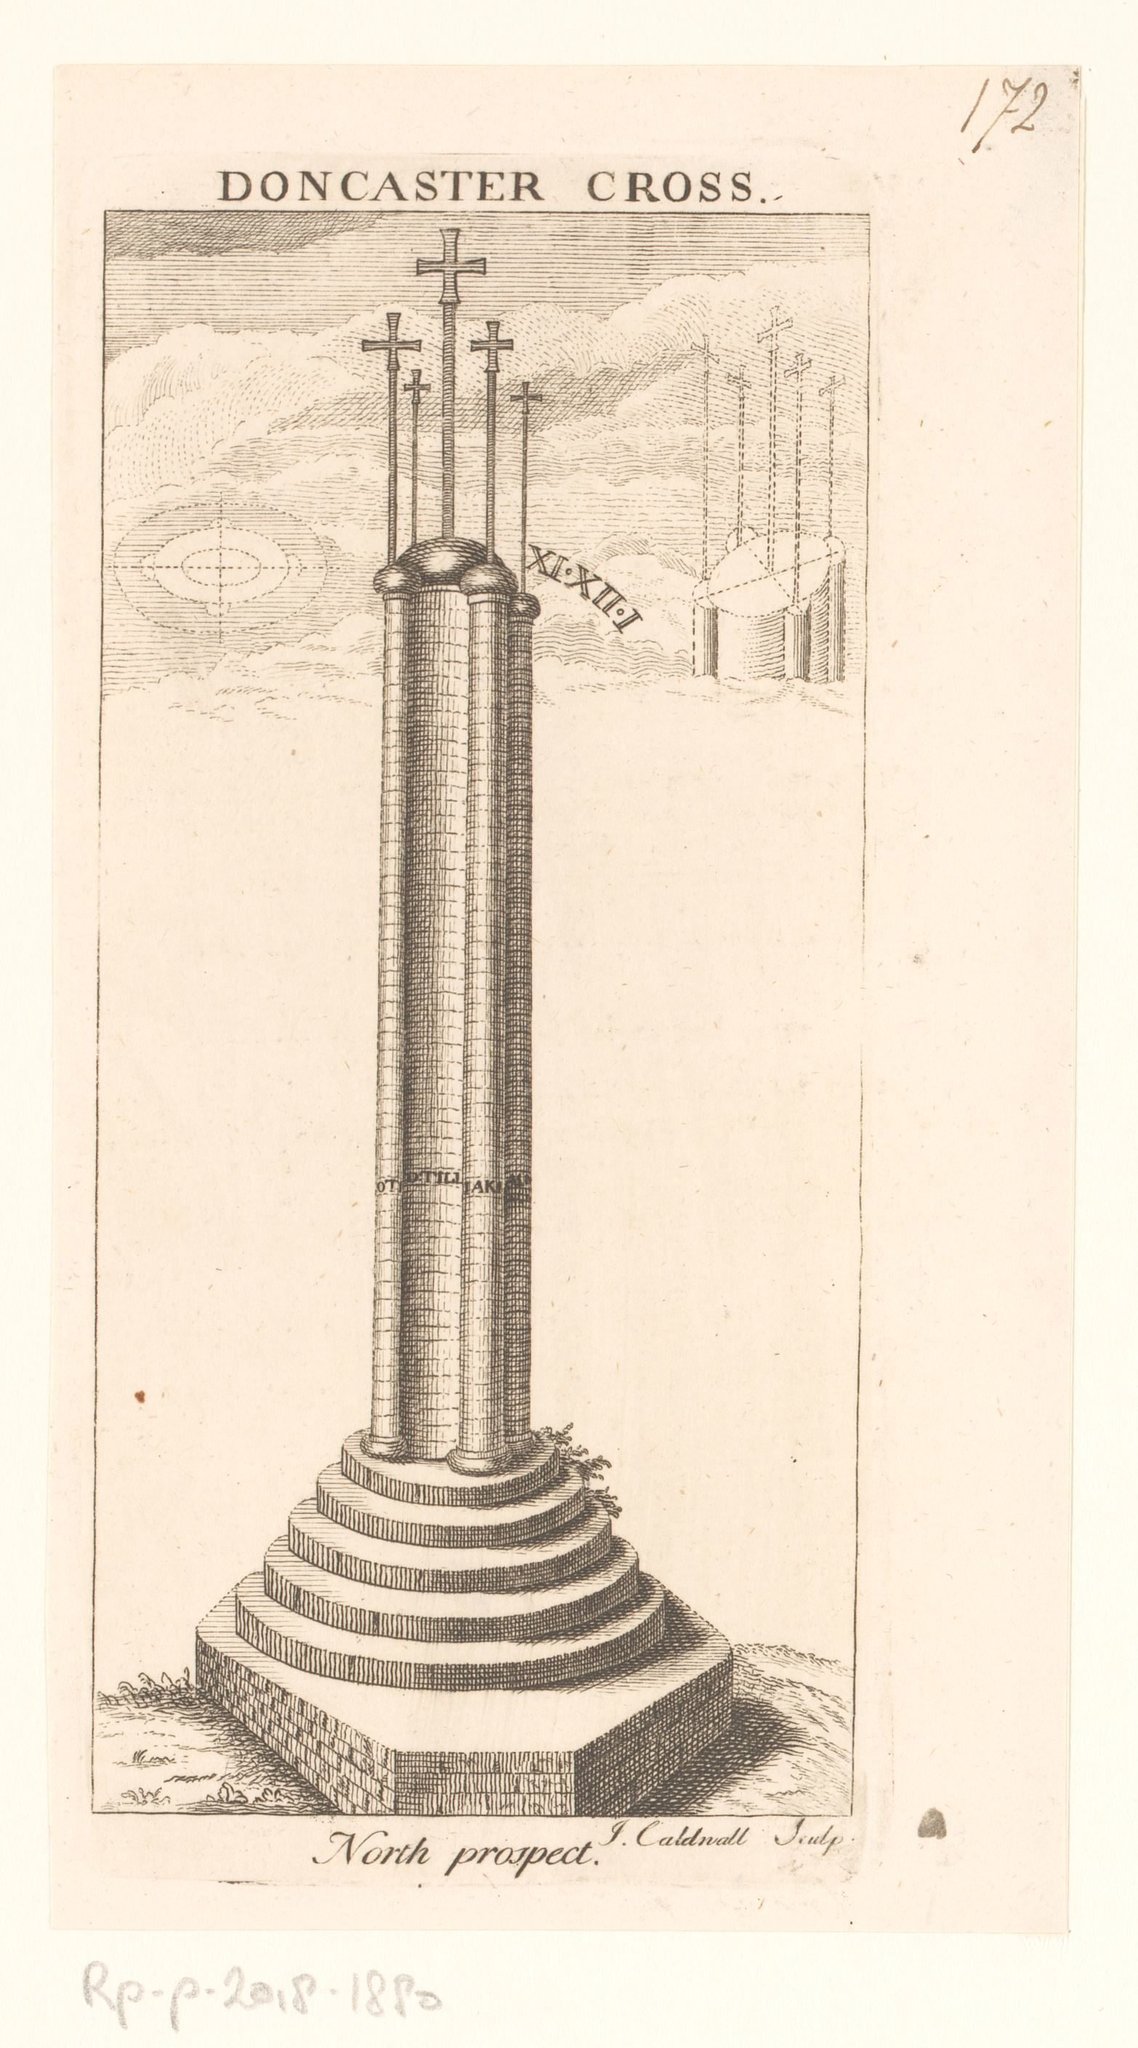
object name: print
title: Gezicht op het Doncaster Cross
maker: james caldwall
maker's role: print maker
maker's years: 1739-1822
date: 1749-1793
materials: paper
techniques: engraving, etching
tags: the cross ~ symbols of christ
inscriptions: collector's mark: Lugt 2228